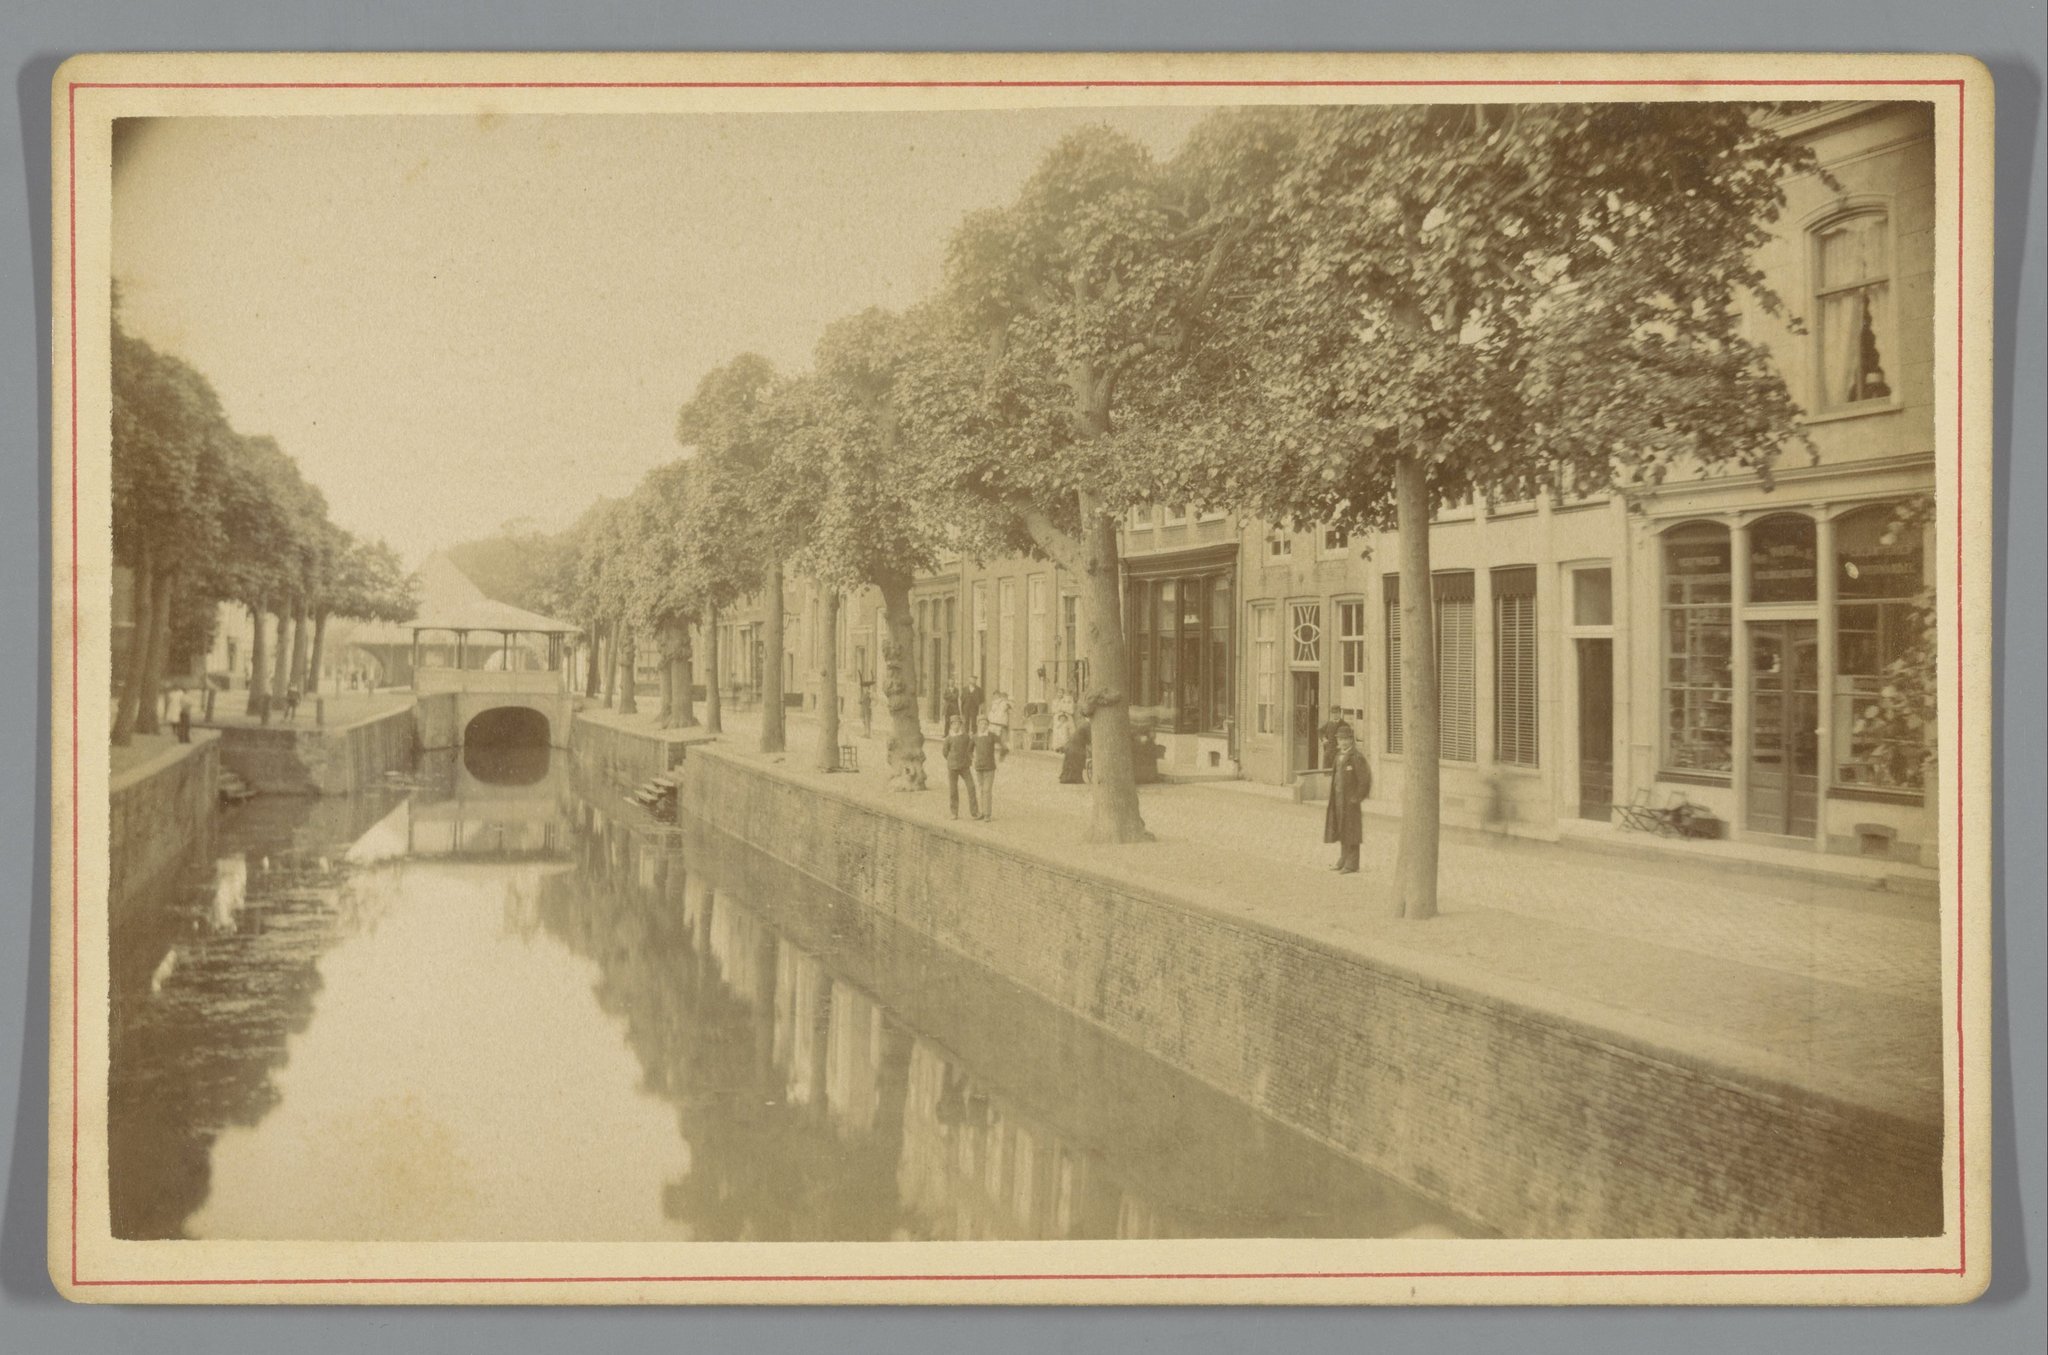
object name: cabinet photograph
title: Schoonhoven. Haven Oostzijde van de Steenen brug gezien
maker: lodewijk hendrikus serré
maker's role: fotograaf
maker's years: 1847-1897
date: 1882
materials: cardboard, paper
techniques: albumen print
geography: schoonhoven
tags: canals, waters (in city)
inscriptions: collector's mark: ‘Vosmaer’, stamp: ‘S. & W. N. van Nooten/ Boekhandel/ Schoonhoven’, inscription: ‘L H Serré Utrecht’